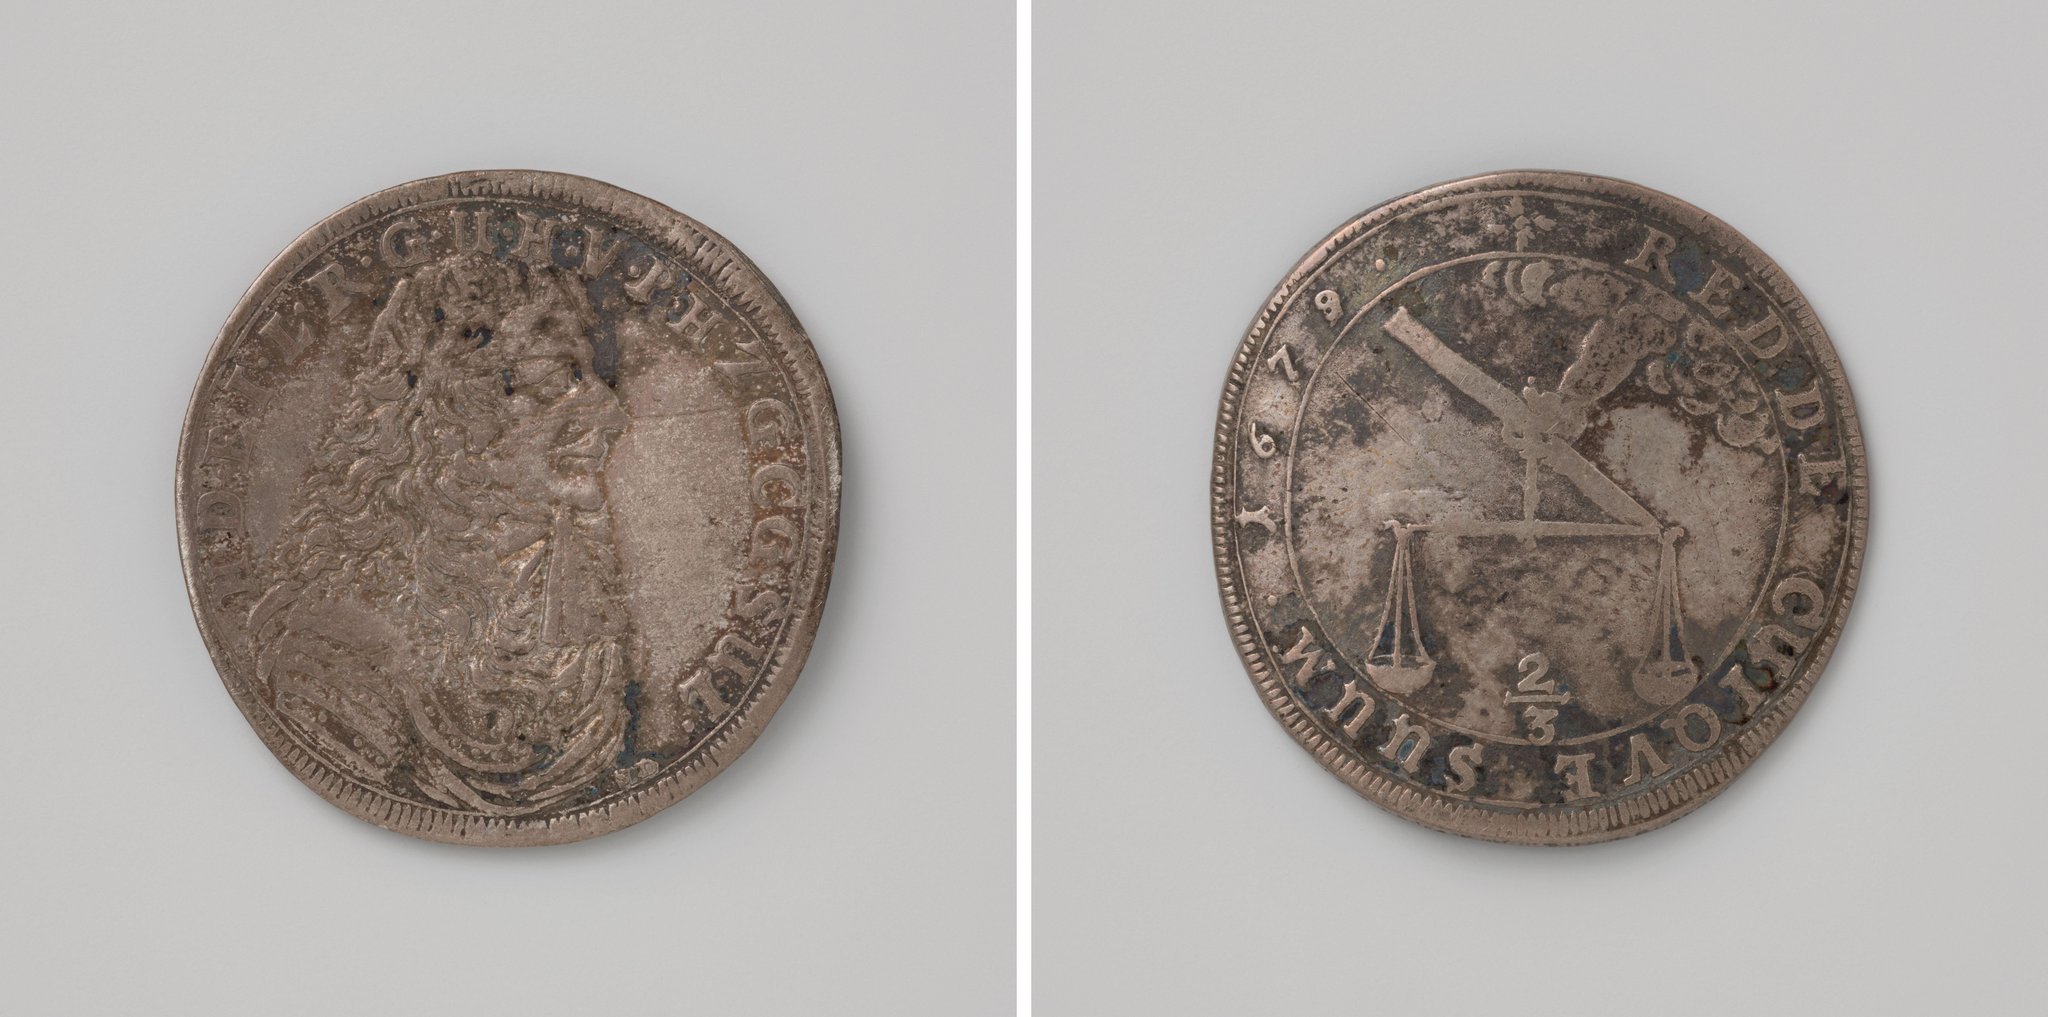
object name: tweederde taler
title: Tweederde taler van Hendrik I van Reuss-Schleiz, over de Vrede van Nijmegen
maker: monogrammist sd (medailleur)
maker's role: medailleur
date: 1679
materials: silver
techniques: striking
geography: germany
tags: nijmegen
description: Voorzijde: borststuk man binnen omschrift. Keerzijde: hand uit wolken houdt weegschaal vast binnen omschrift